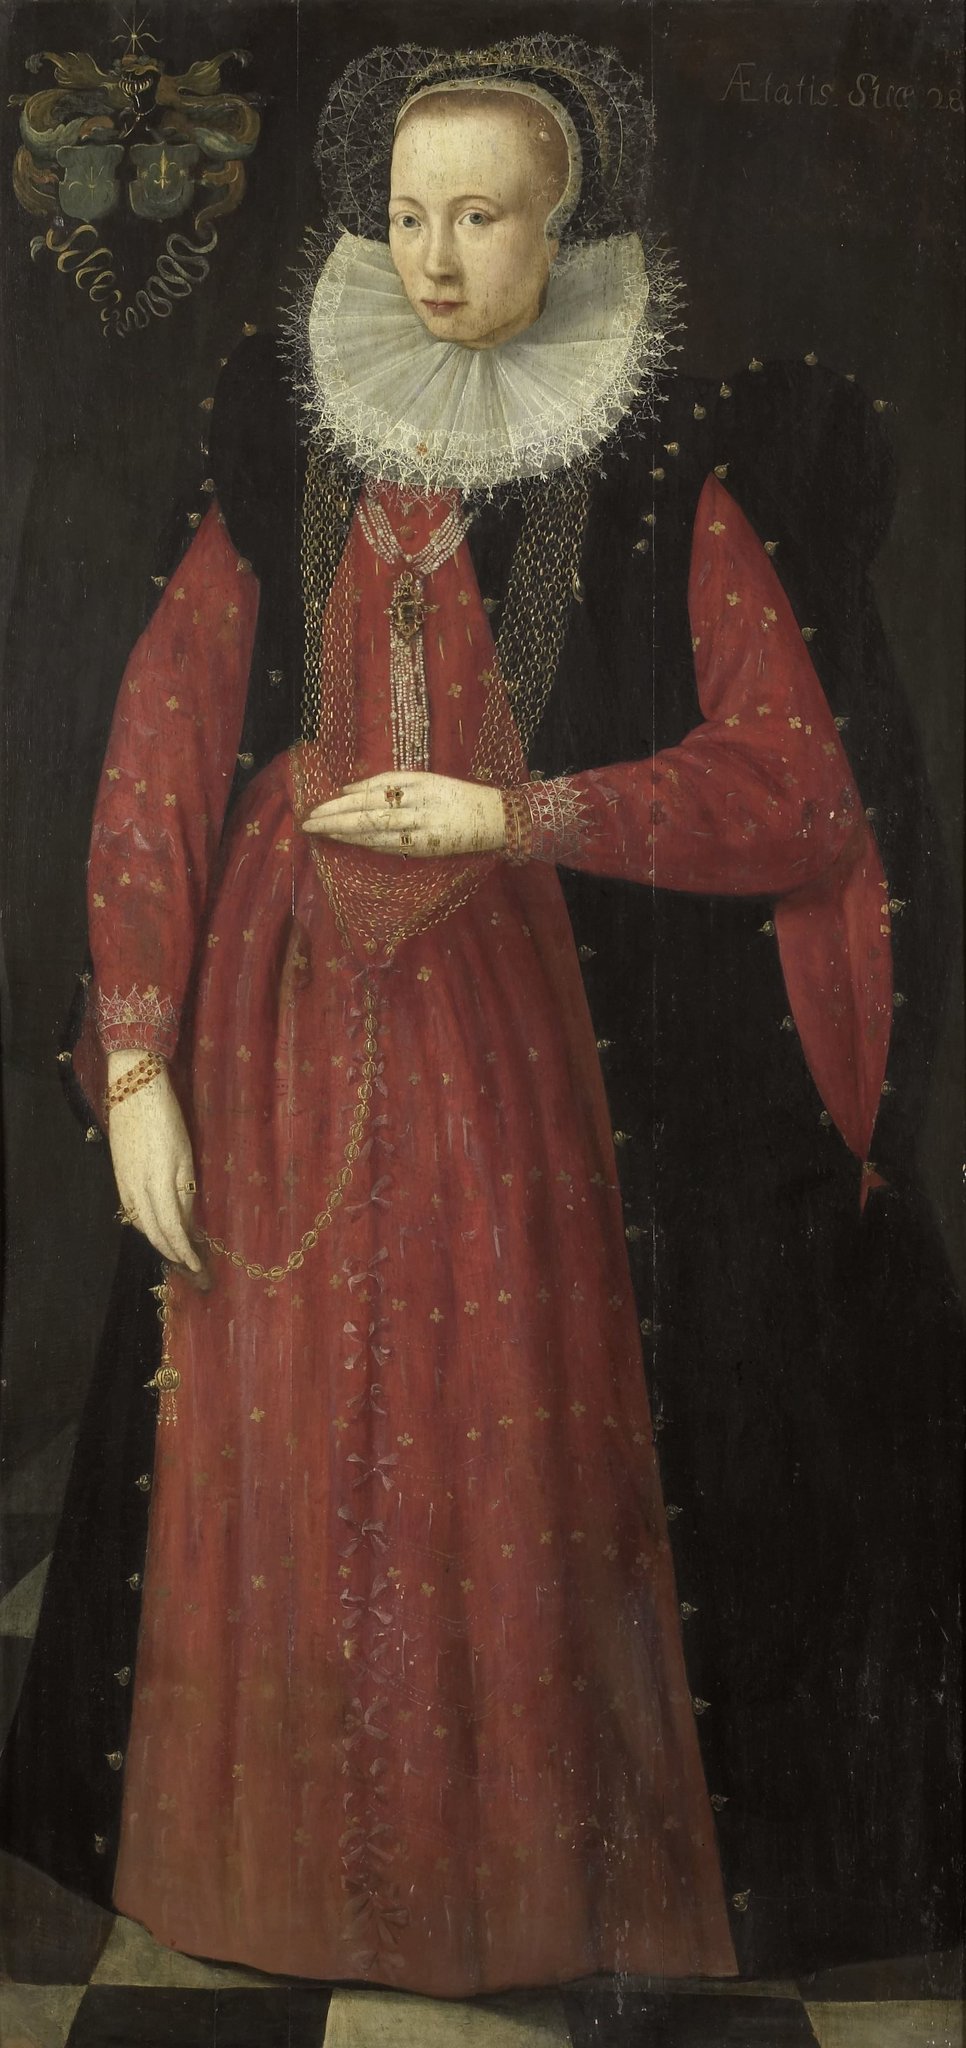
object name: painting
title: Portrait of Doedt van Holdinga (1570-1646)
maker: Anonymous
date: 1598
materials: oil, panel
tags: historical persons - bb - woman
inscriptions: inscription, top right: ‘Aetatis. Suae 28.’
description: Portret van een vrouw uit het geslacht Holdinga, staande, ten voeten uit. Om de hals een aantal kettingen, in de rechterhand de langste ketting waaraan een hanger. Linksboven het familiewapen.